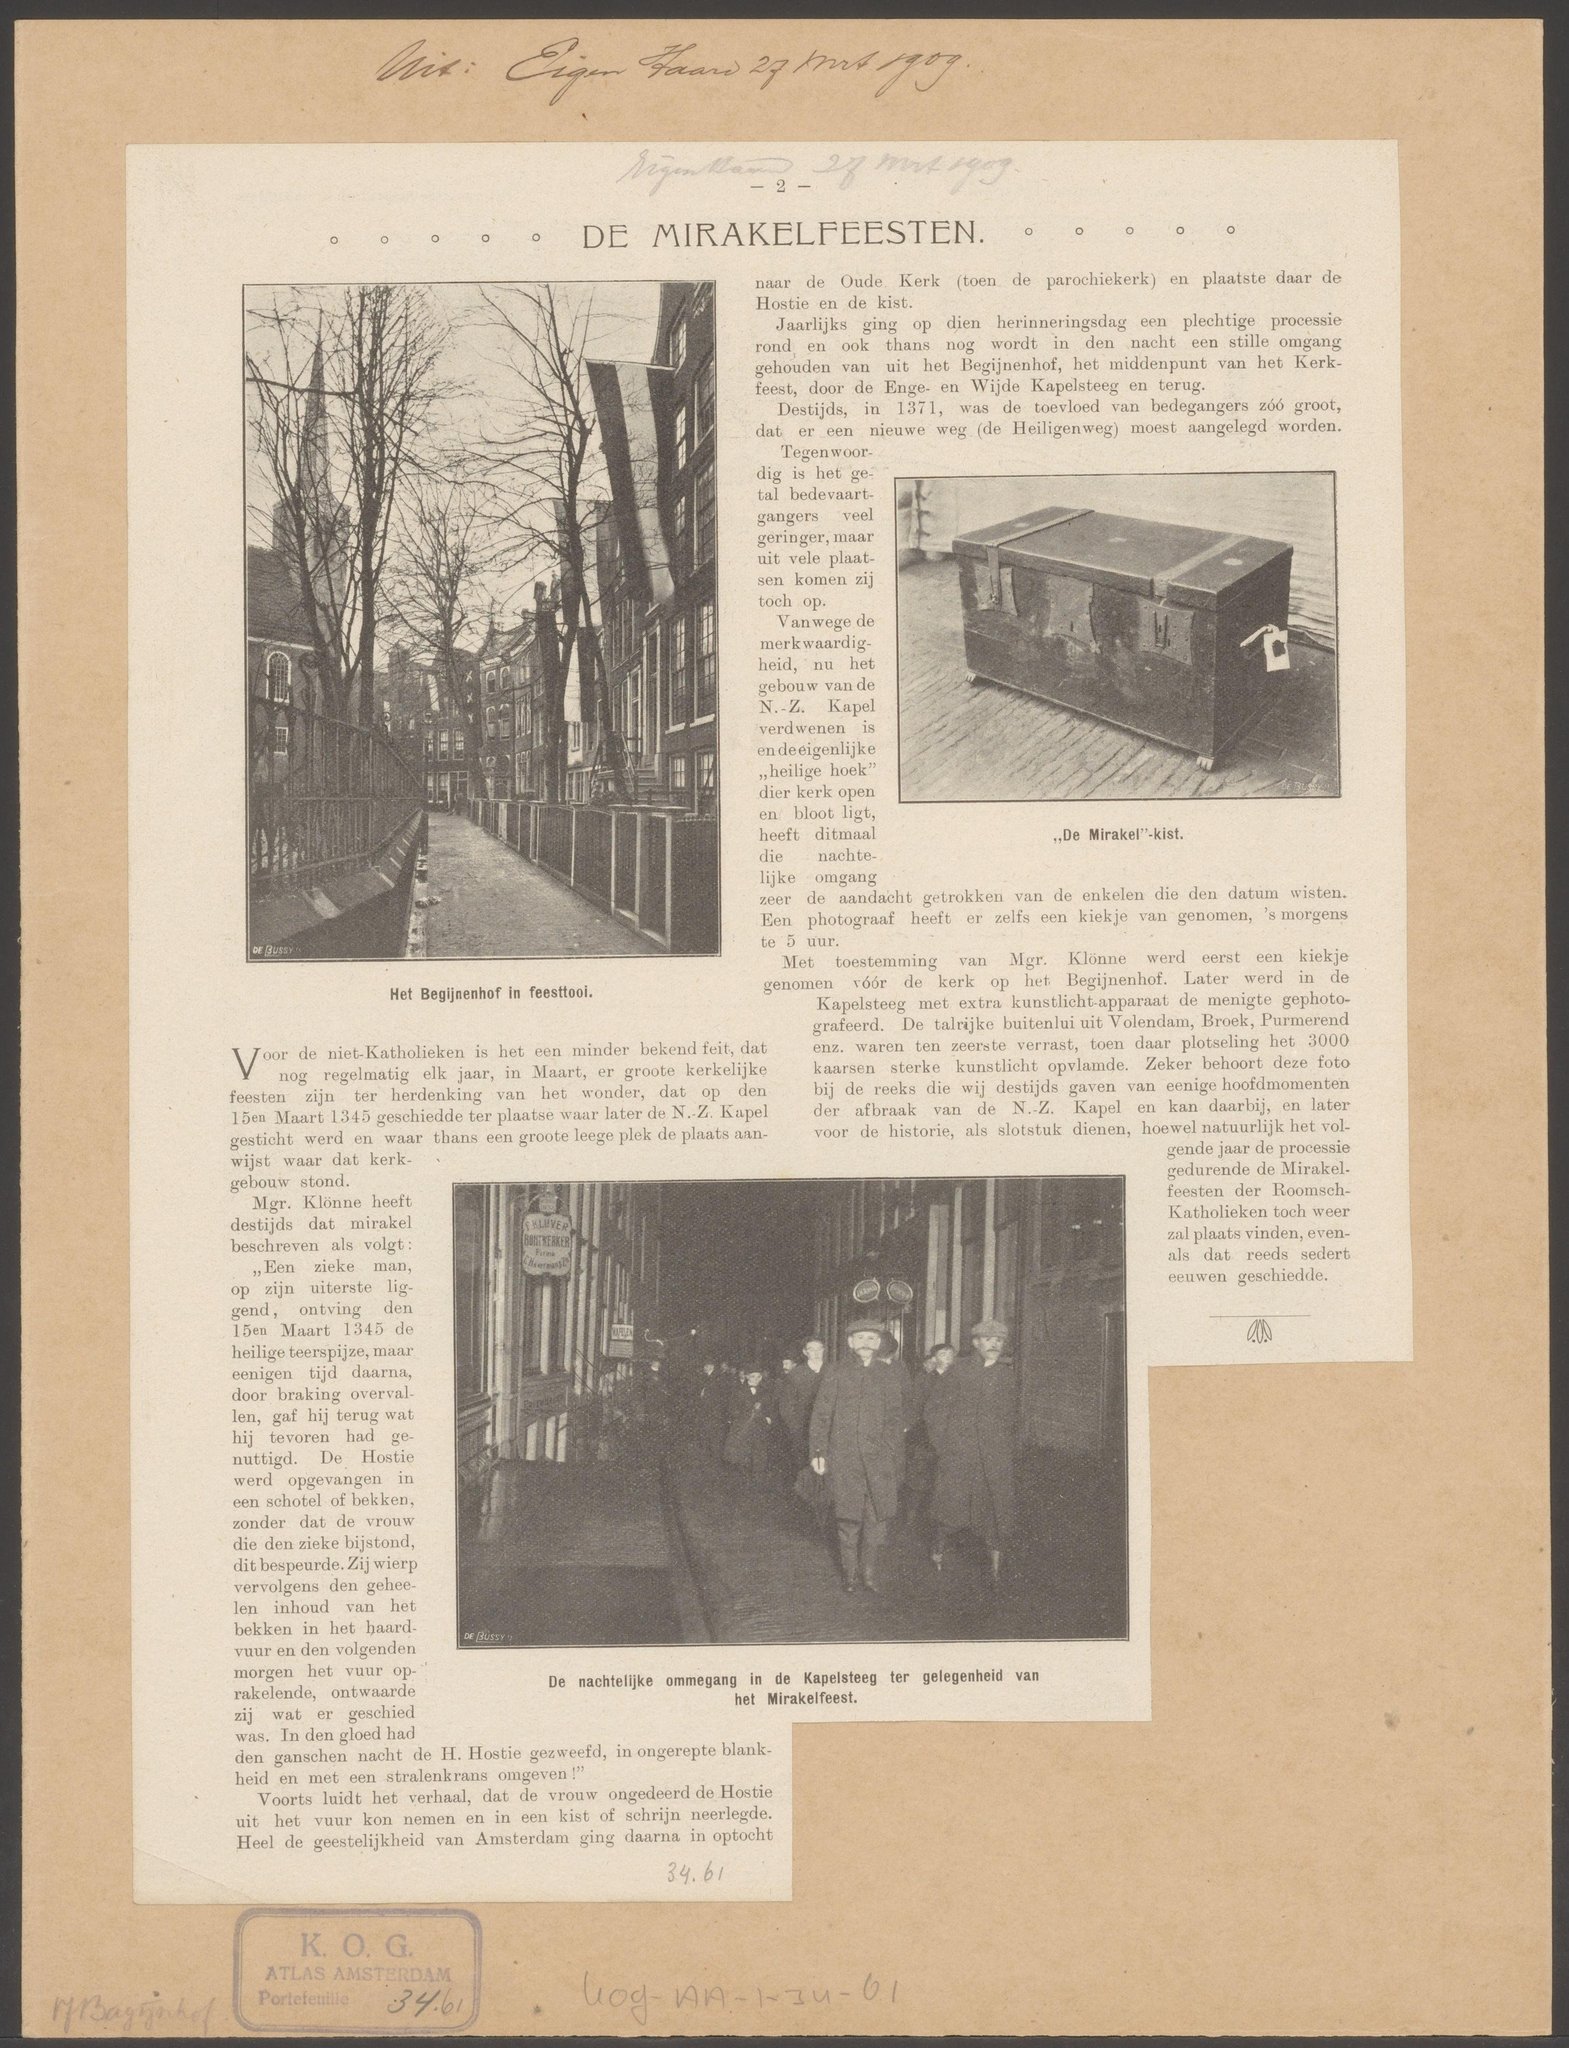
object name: photomechanical print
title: De Mirakelfeesten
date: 1909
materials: paper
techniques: letterpress printing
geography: amsterdam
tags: procession ~ christian religion, chest, coffer, street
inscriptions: collector's mark: Lugt 1641b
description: Onderwerpsrubriek binnen de Atlas Amsterdam: Kerkwezen: R.K. Gemeenten: Heilige Stede.